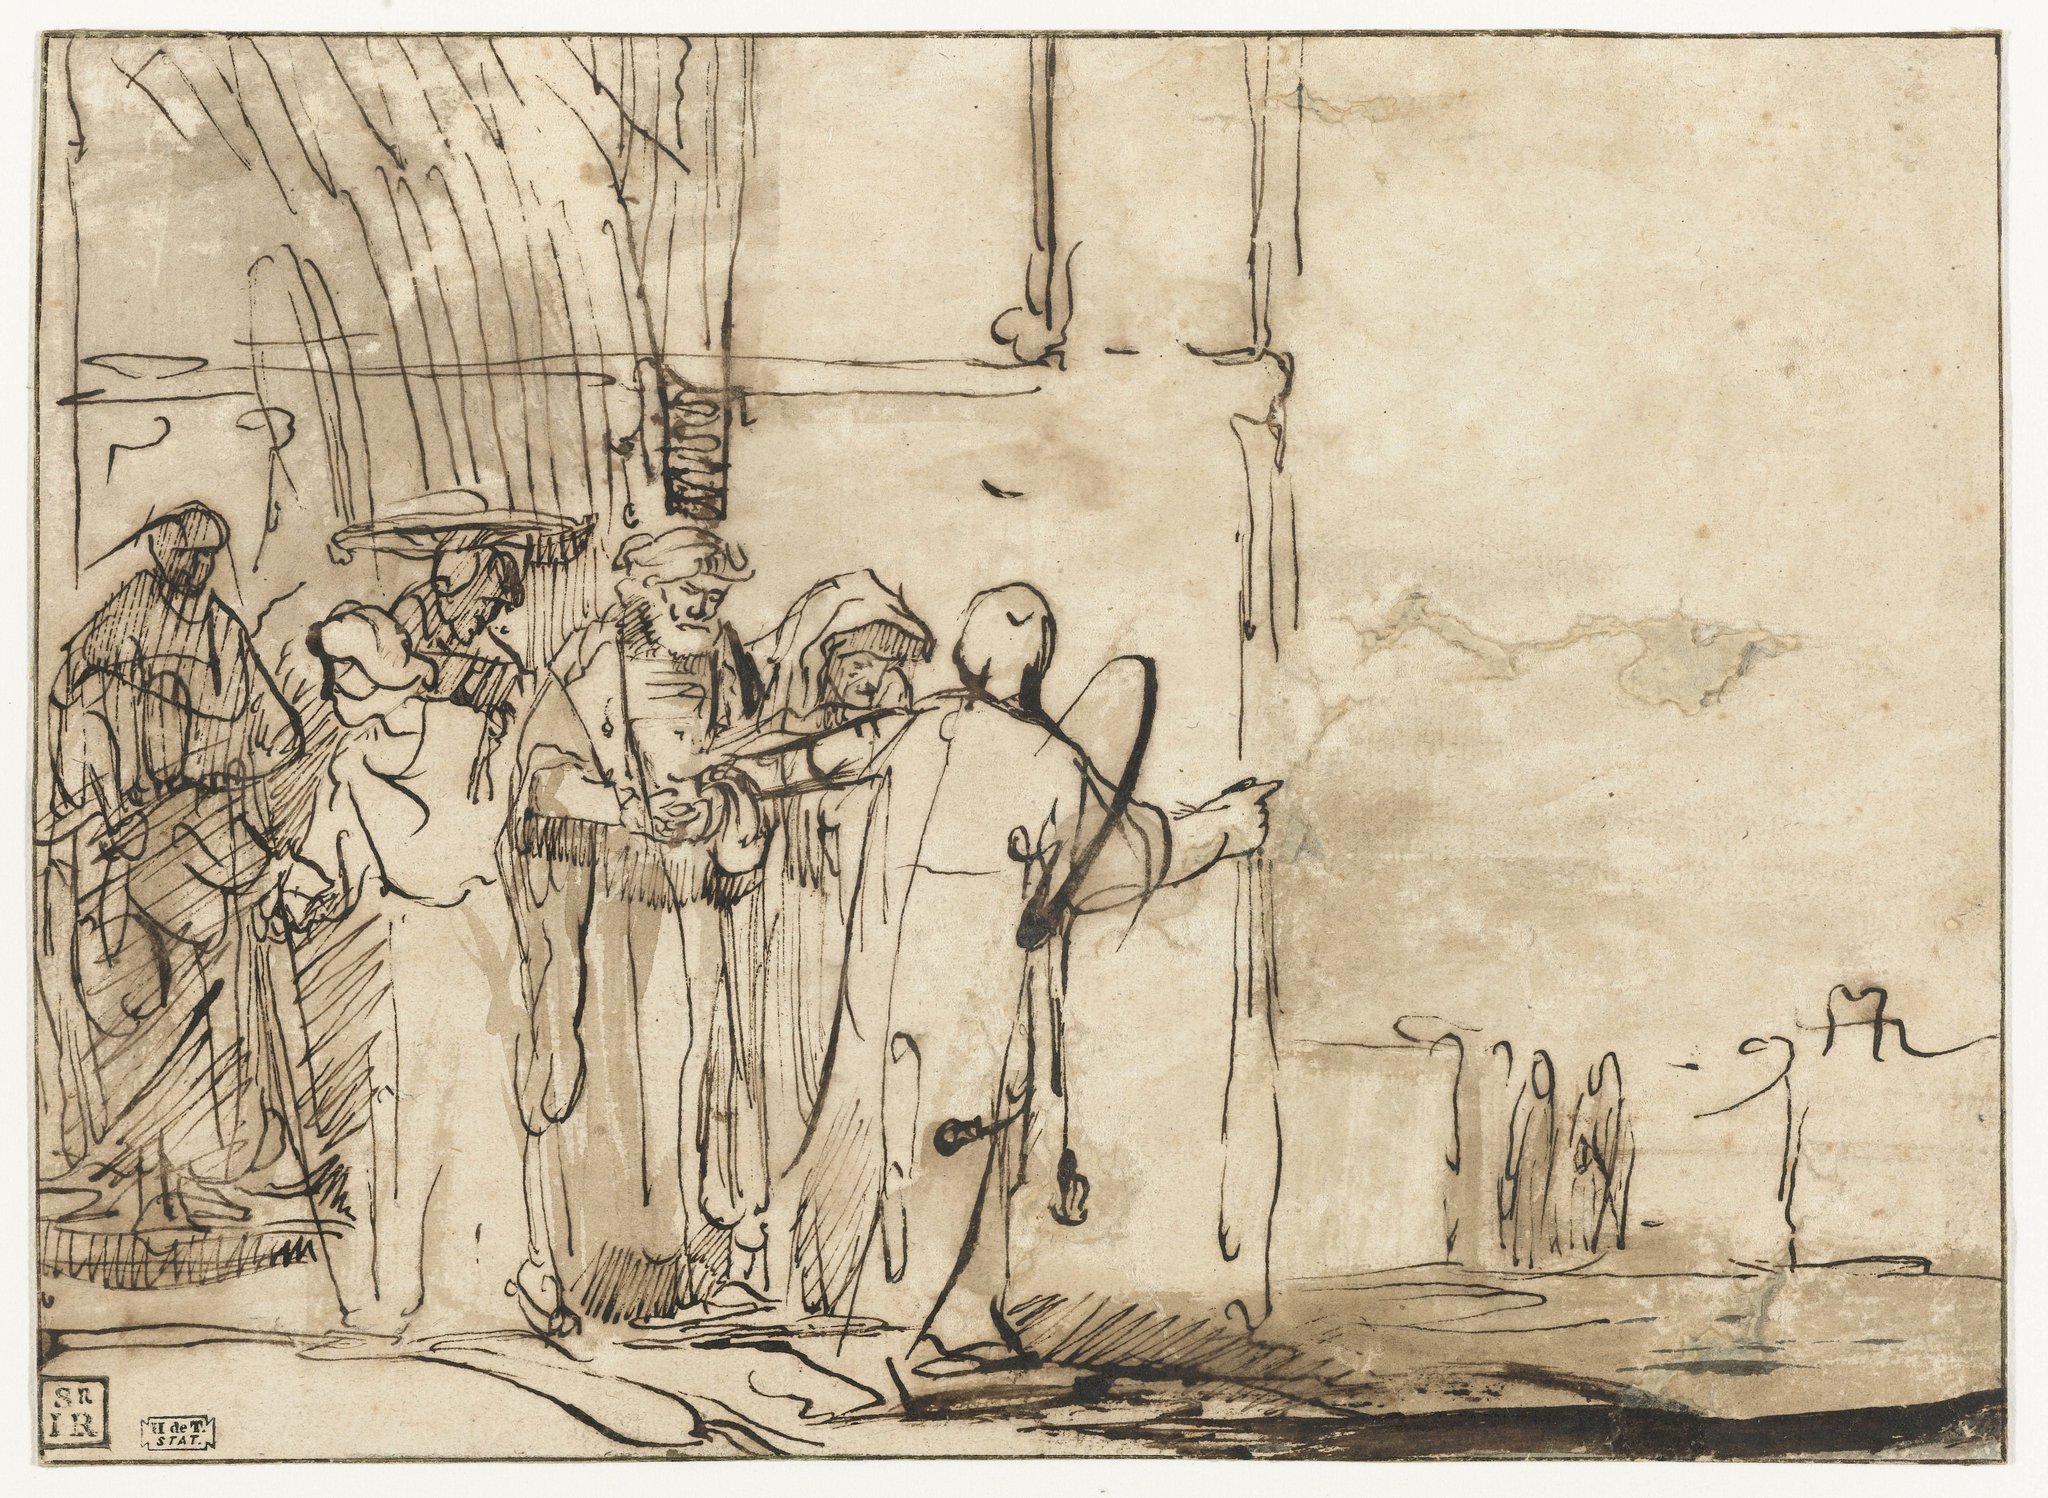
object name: drawing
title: Lot and his Family Leaving Sodom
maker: Anonymous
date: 1635-1700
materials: ink, paper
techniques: brush, pen